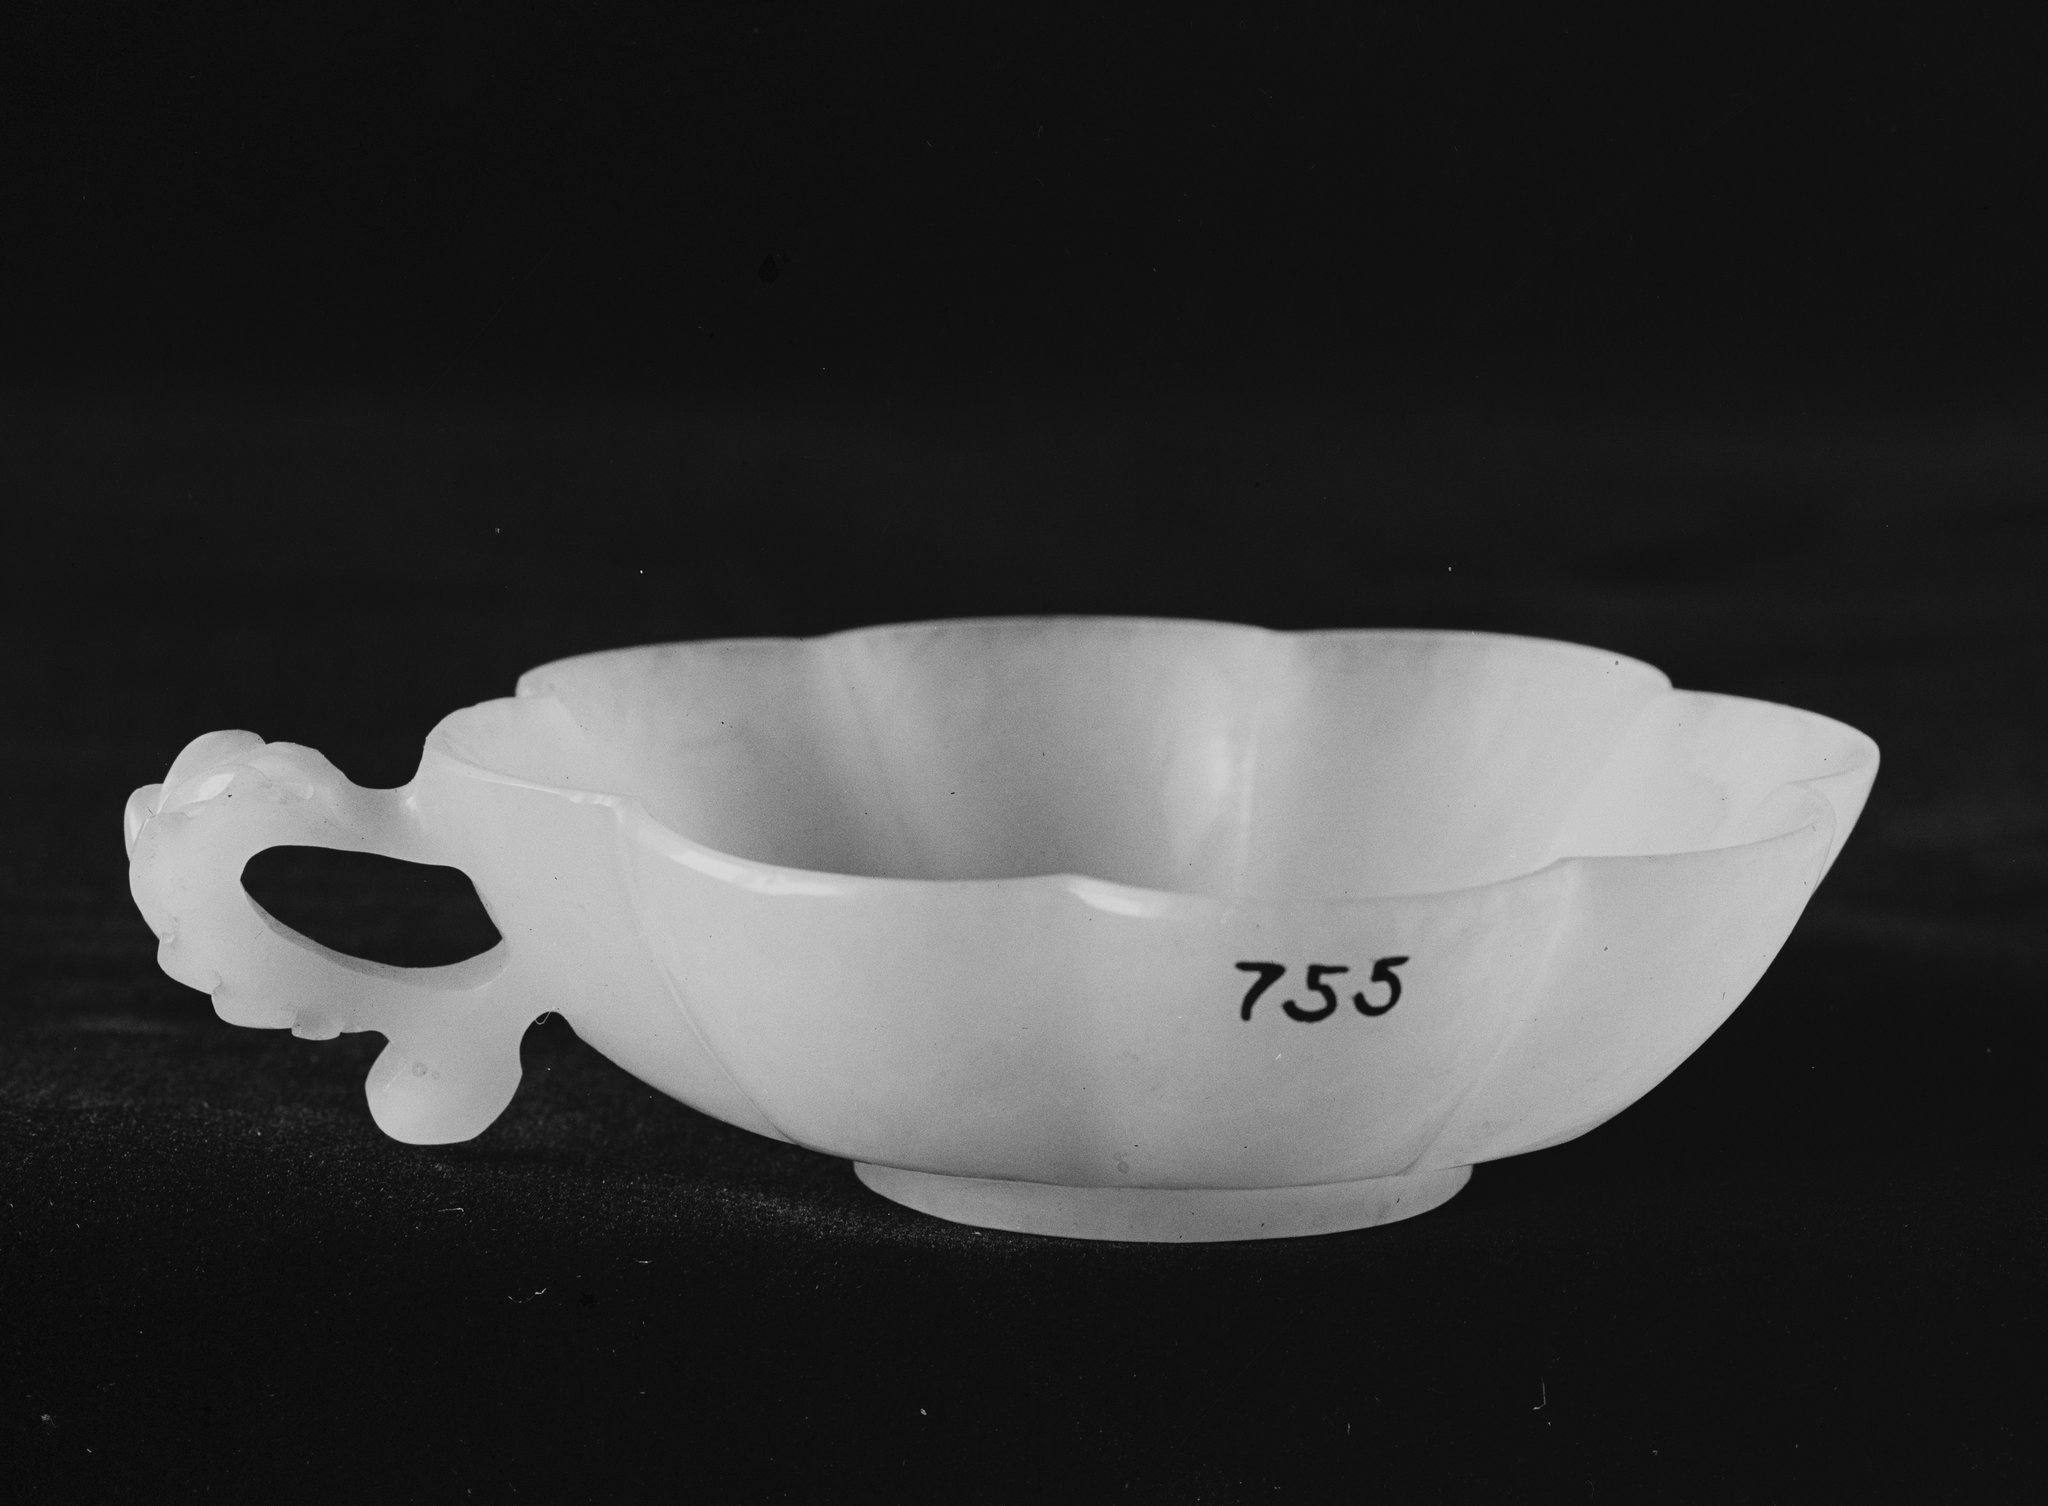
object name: wine cup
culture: indian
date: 1701-1800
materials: jade